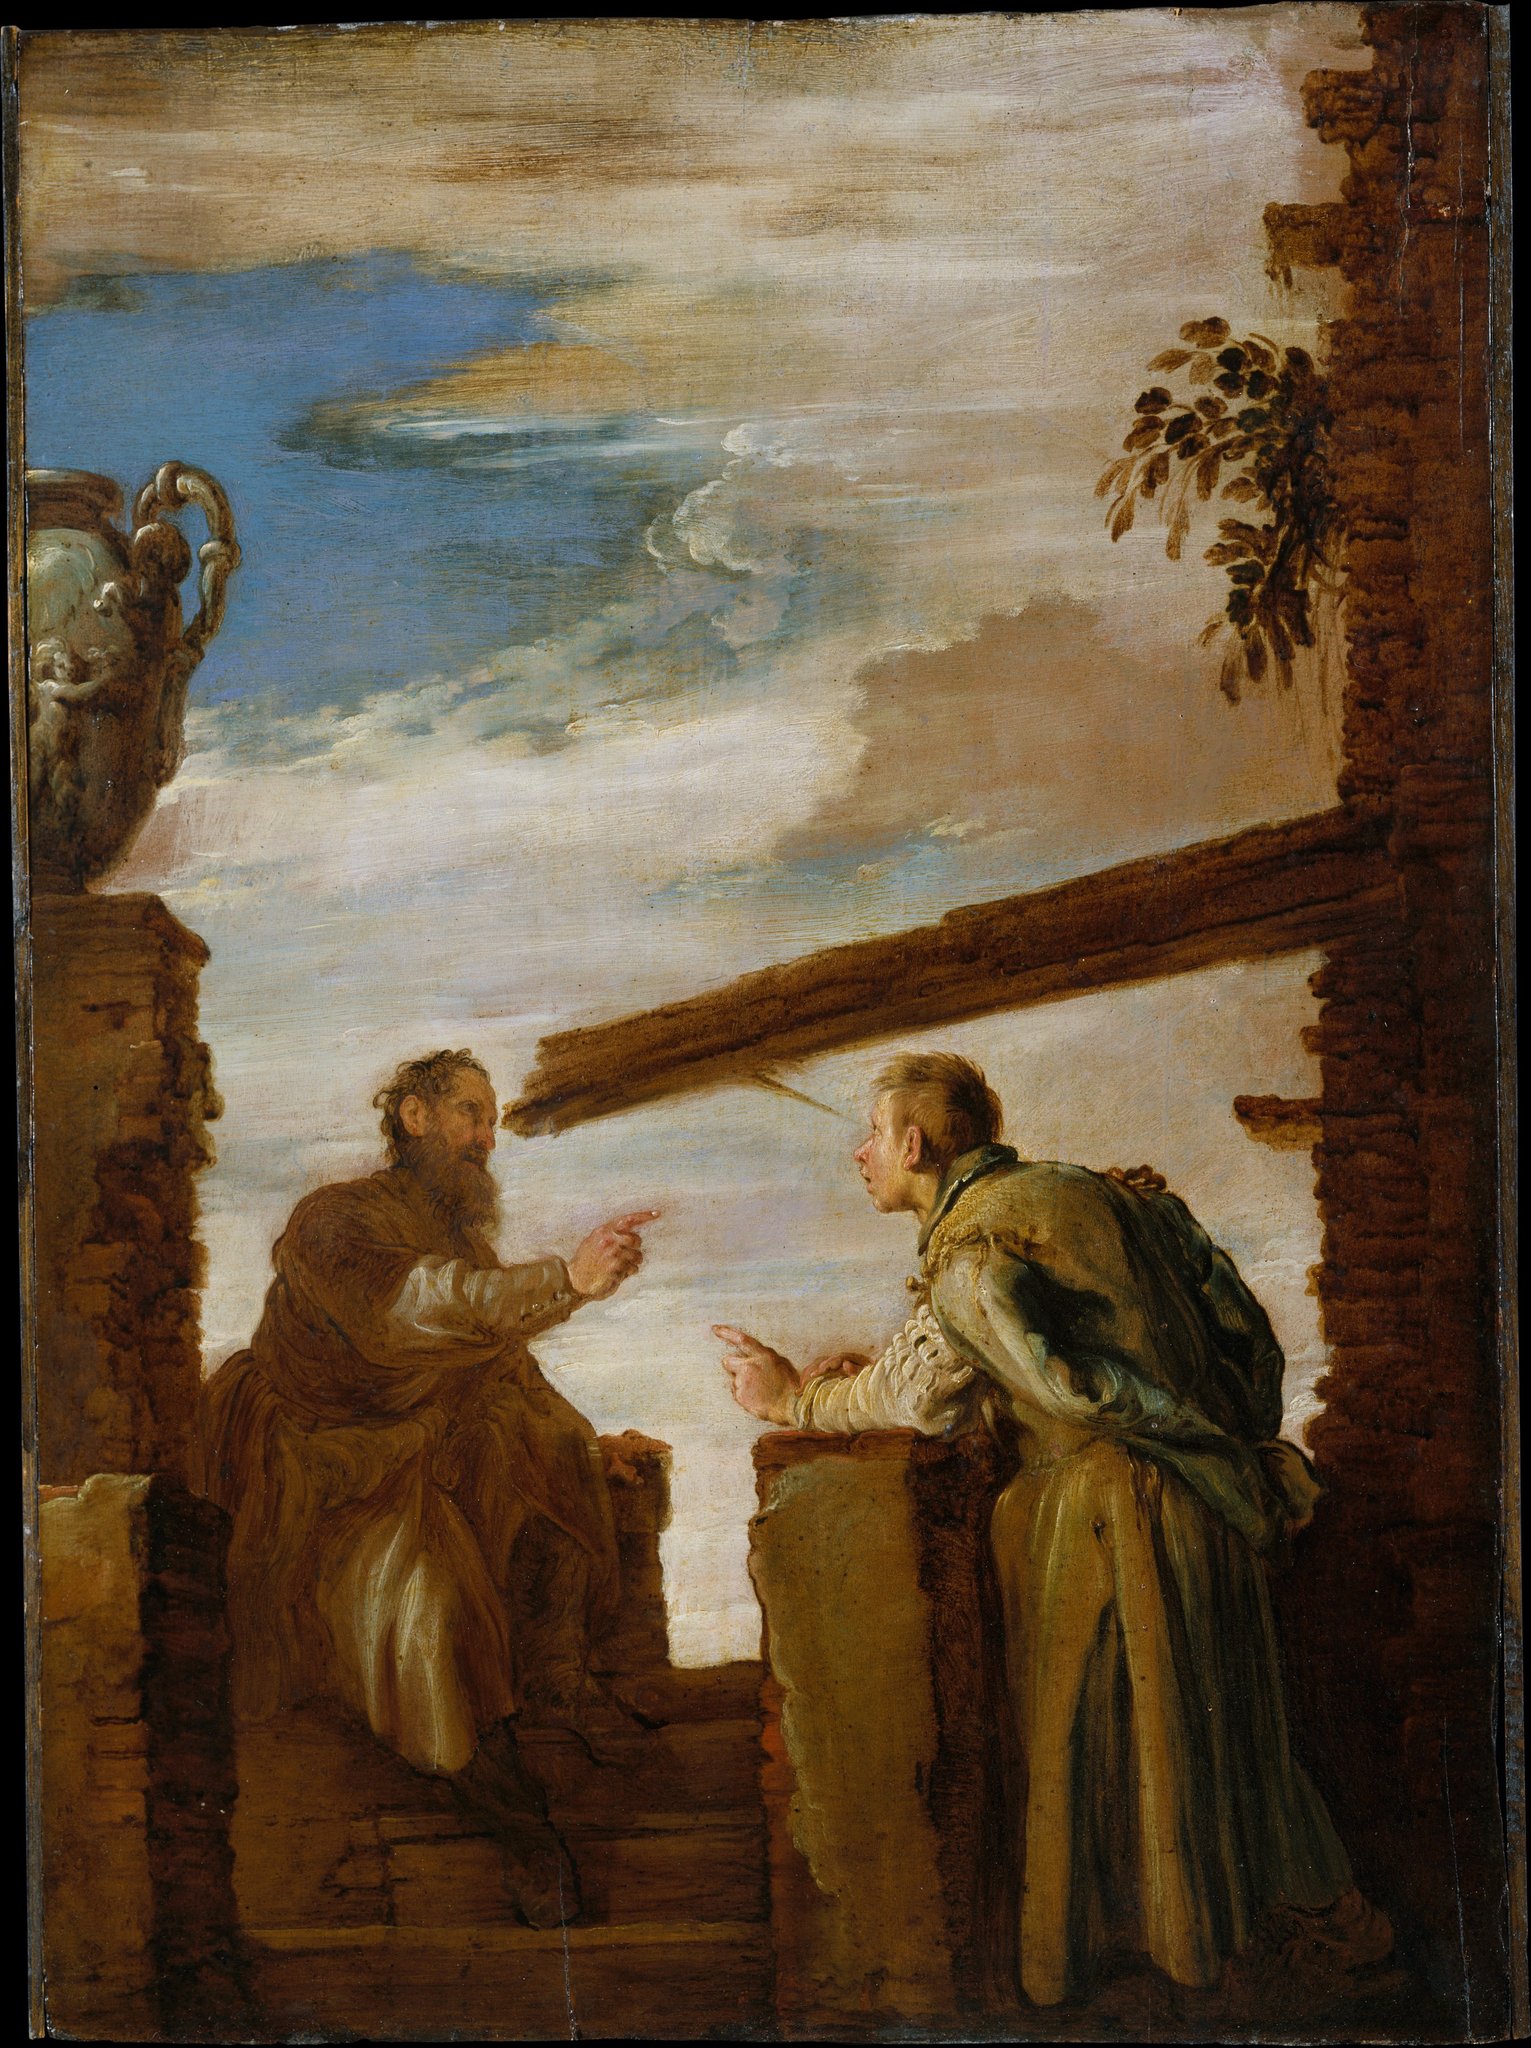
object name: painting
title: The Parable of the Mote and the Beam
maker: domenico fetti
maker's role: artist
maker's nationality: italian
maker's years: 1591-1623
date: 1619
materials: oil, wood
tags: men,parables